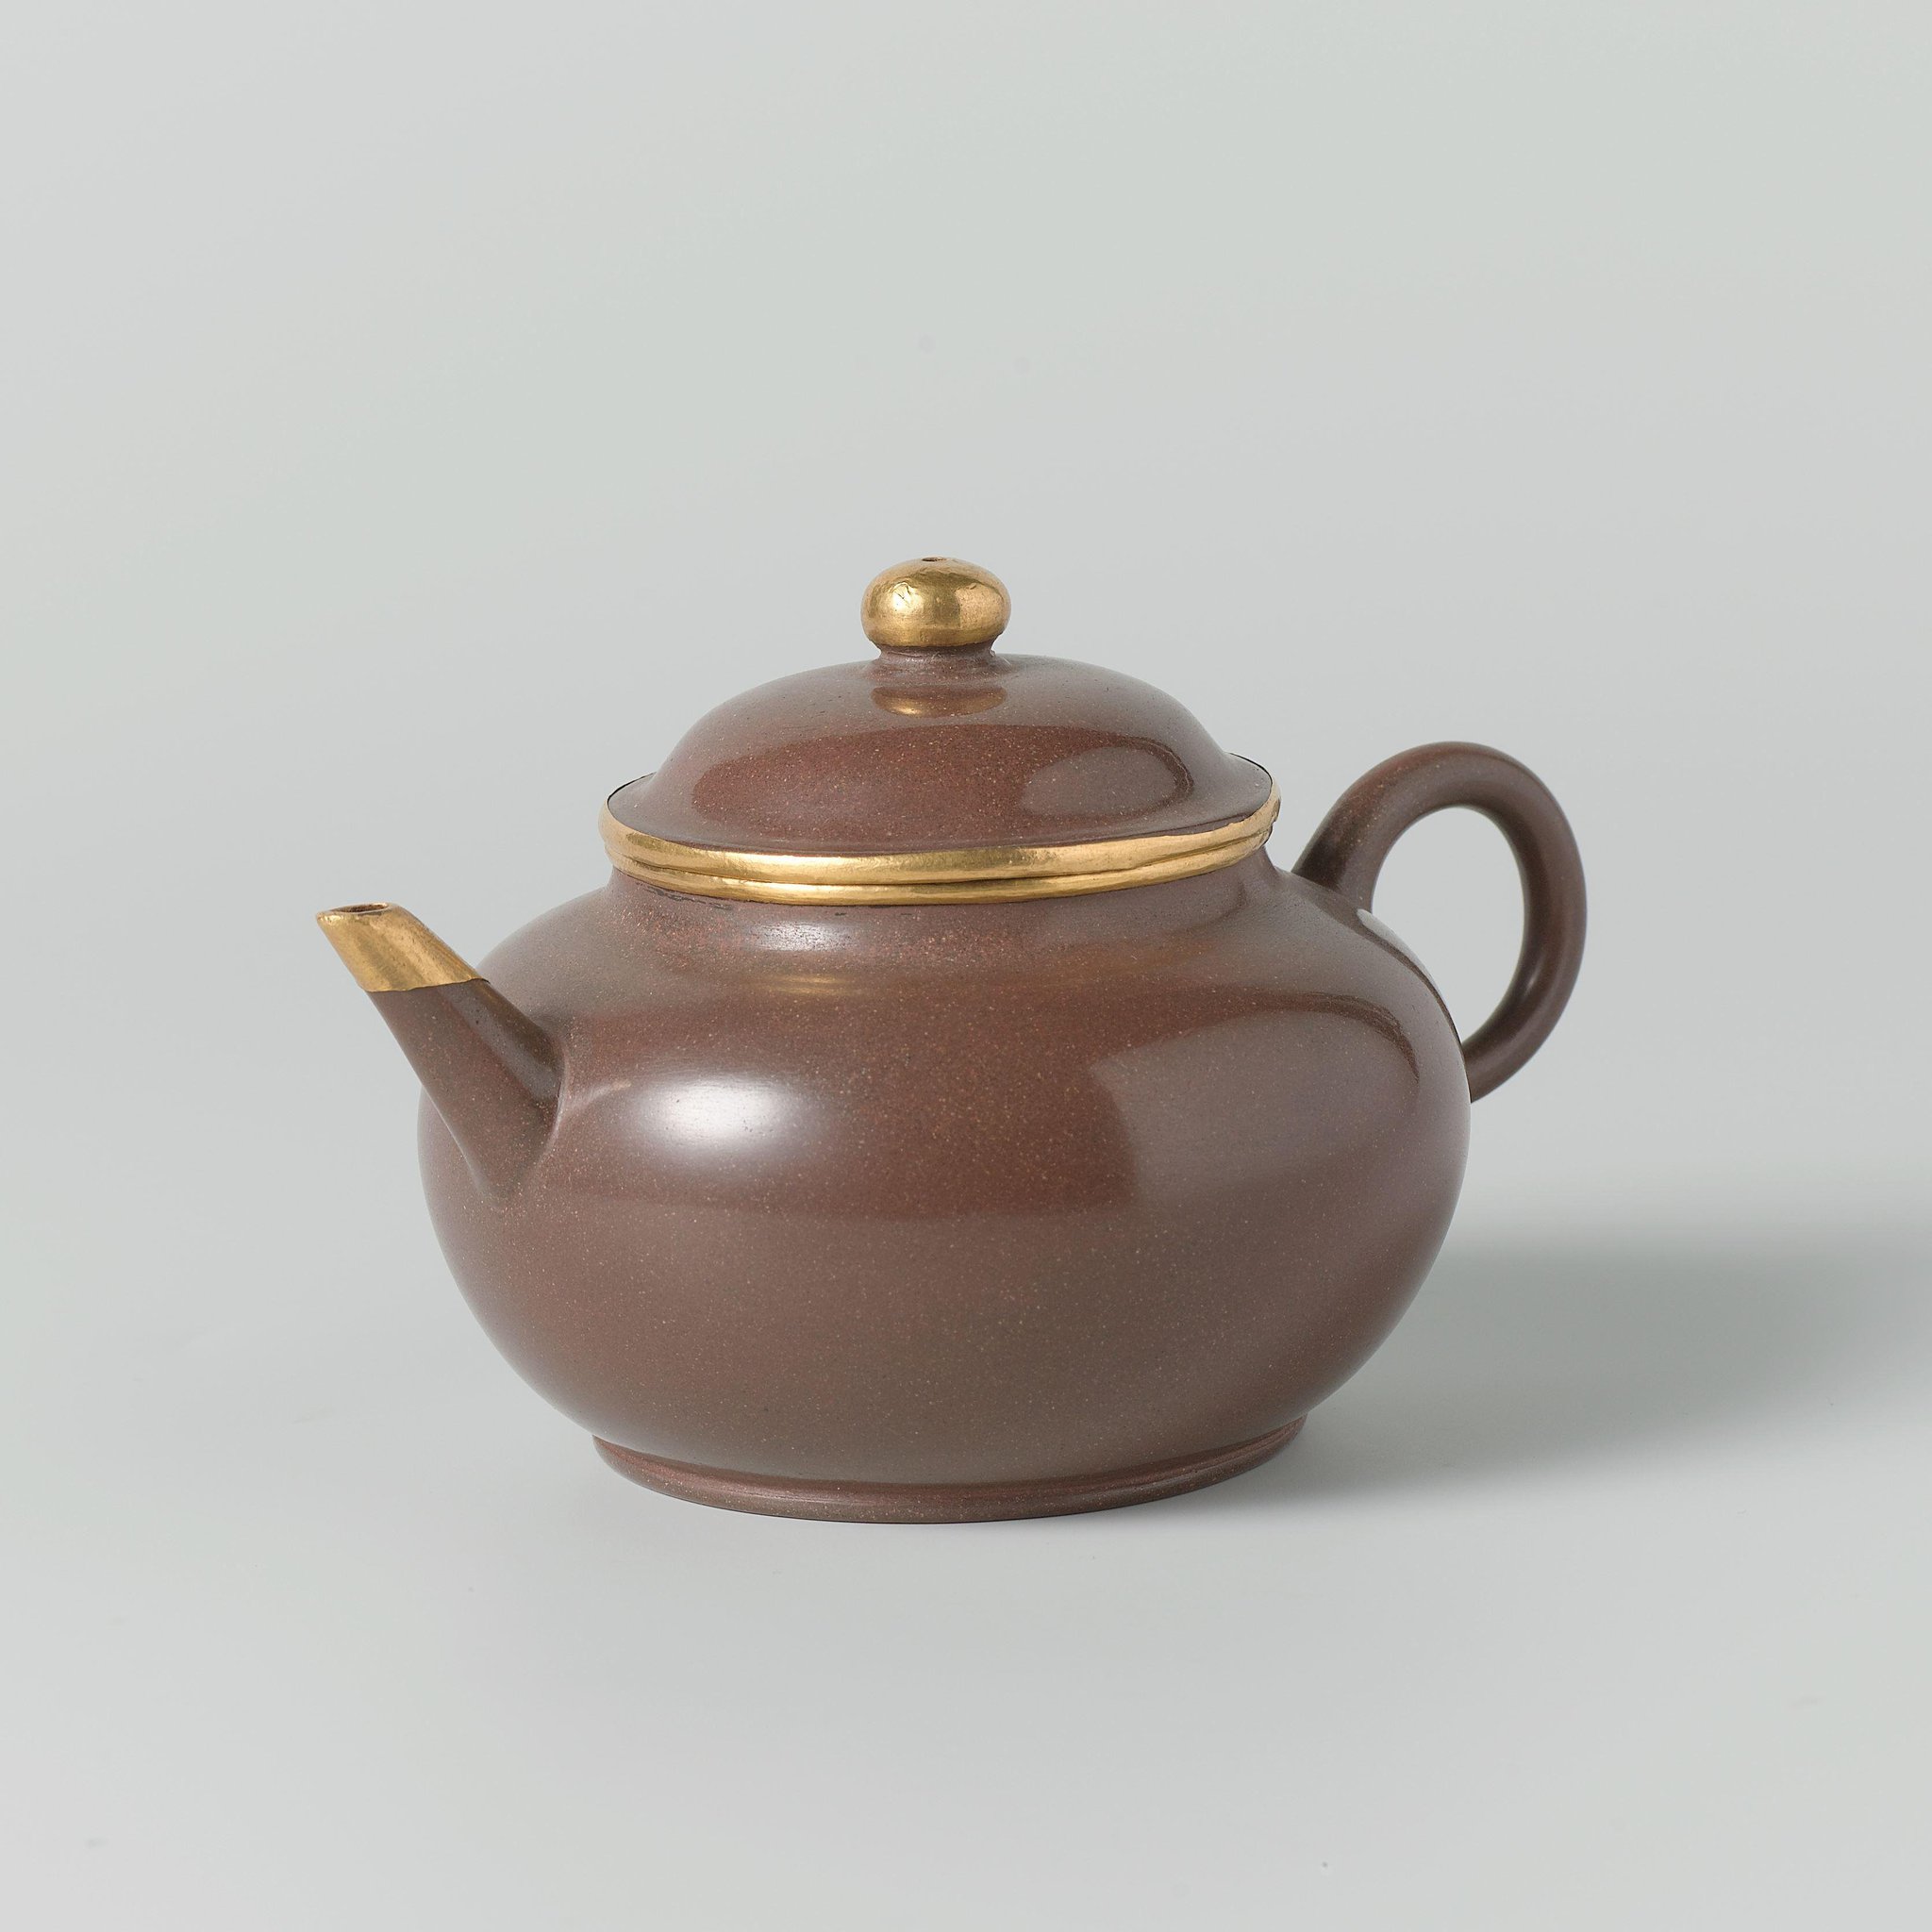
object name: teapot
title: Teapot with Polished Surface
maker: Anonymous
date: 1800-1899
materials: gold, stoneware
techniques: firing, polish, turning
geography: china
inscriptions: mark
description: This teapot stands out for its smooth polished surface and gold rims. Yixing teapots are popular in Southeast Asia, which has a tea culture akin to that of China. Teapots of this type were made in Yixing and then fitted with decorations in Thailand to suit that country’s tastes.